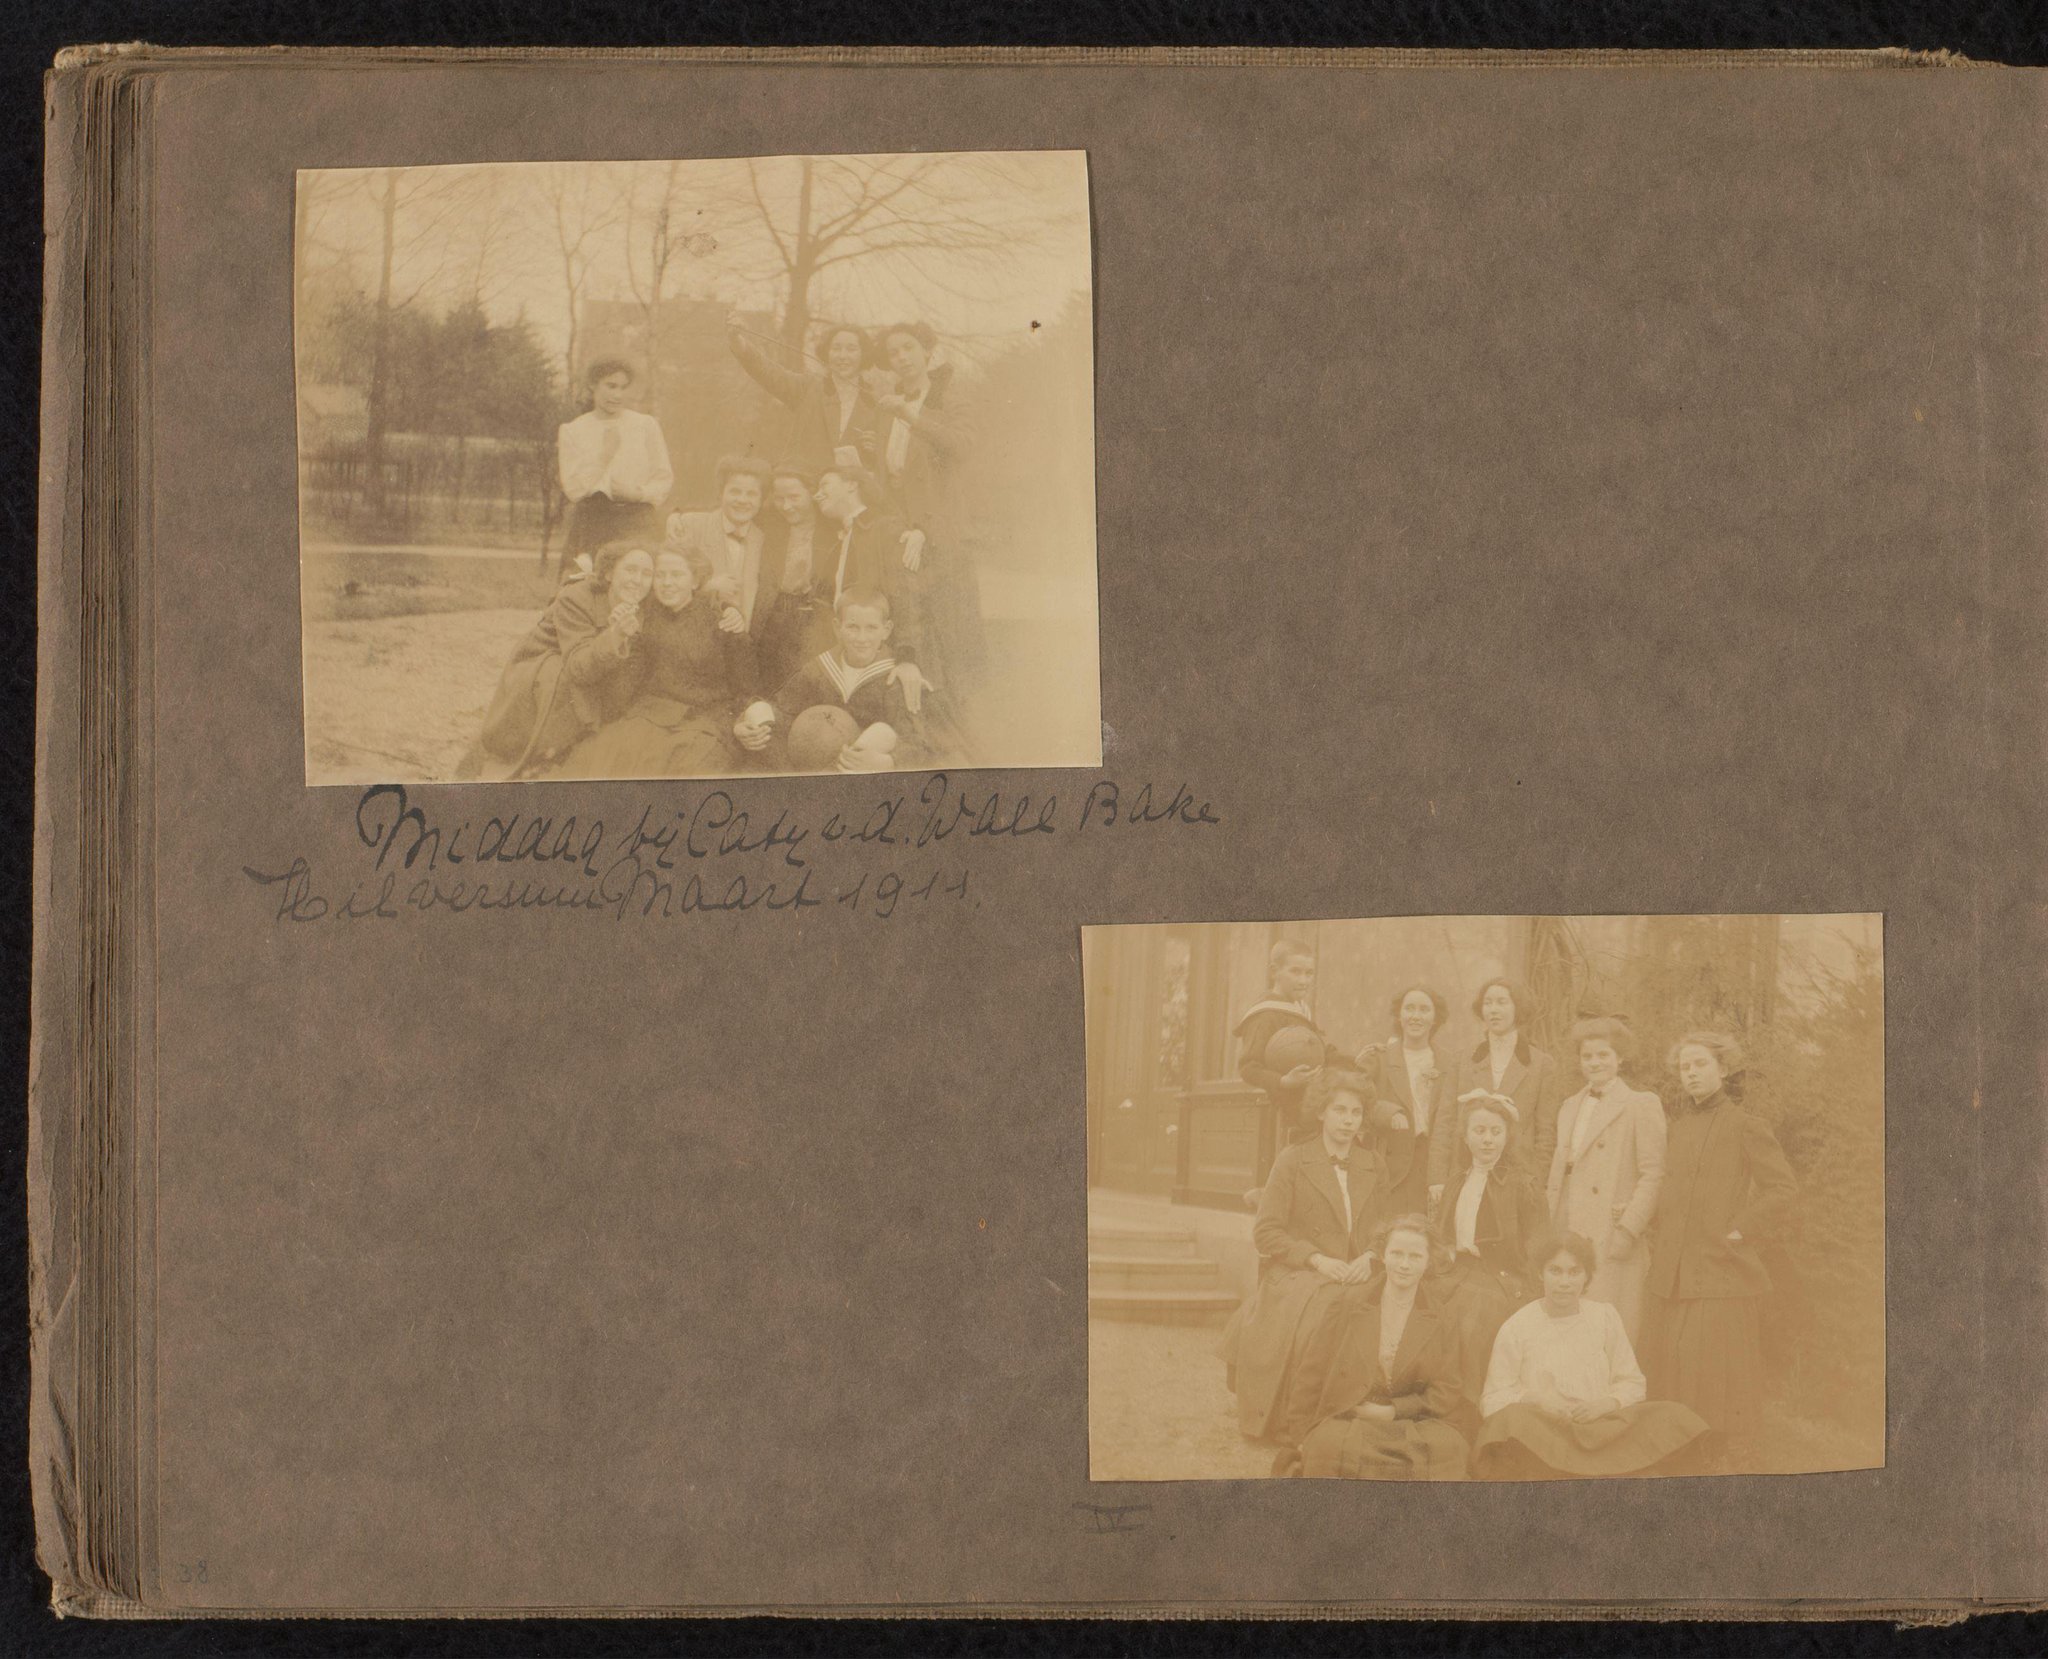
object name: photograph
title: Middag bij Caty v.d. Wall Bake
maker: carolina frederika onnen (lien/loen)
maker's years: 1896-1983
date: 1903-1911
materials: paper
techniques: gelatin silver print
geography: hilversum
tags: amsterdam, carolina frederika onnen (lien/loen), friends, anonymous historical persons portrayed in a group, in a group-portrait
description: Deze foto's maken deel uit van een album.